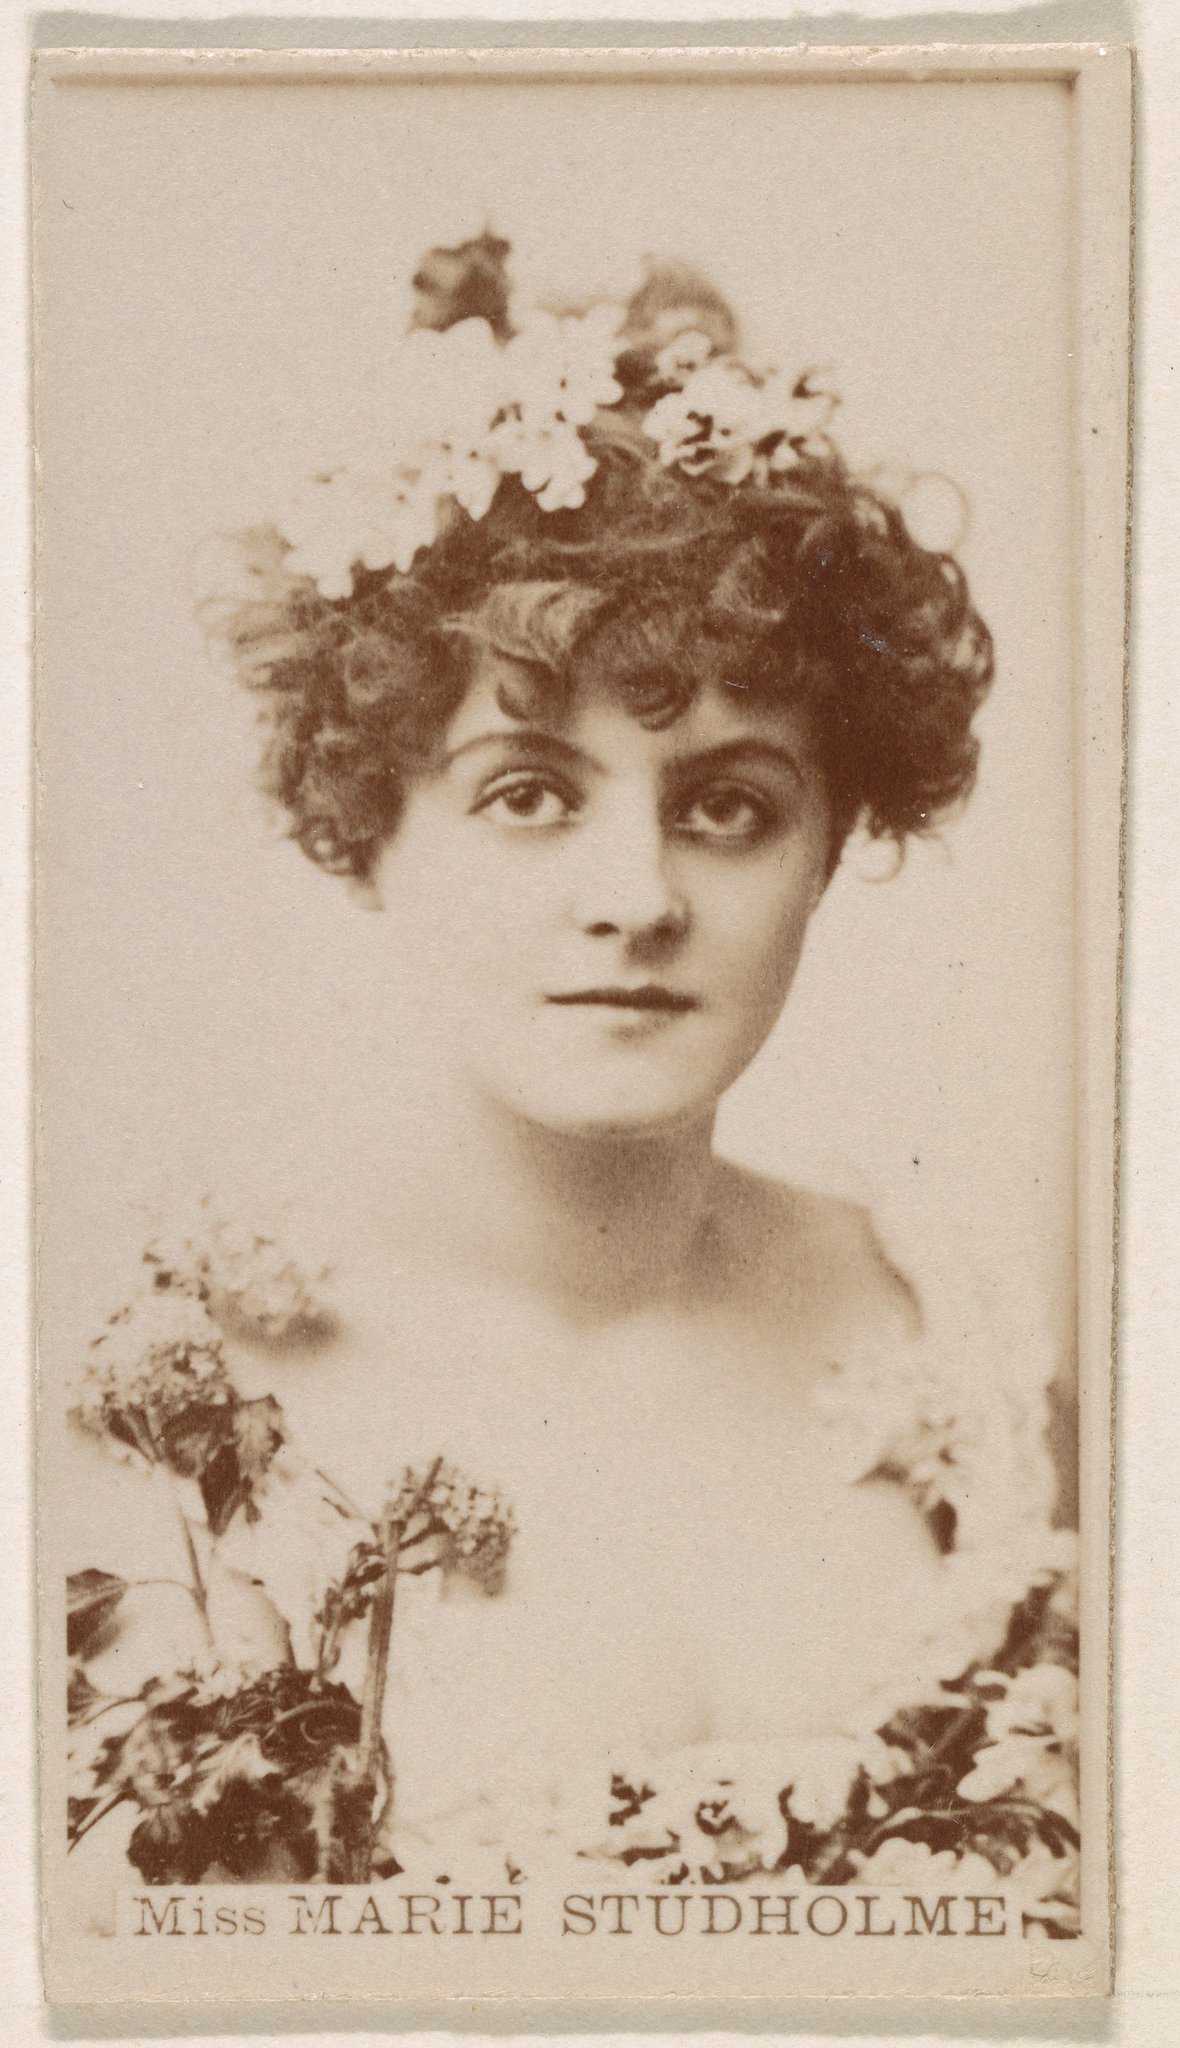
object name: photograph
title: Miss Marie Studholme, from the Actresses series (N245) issued by Kinney Brothers to promote Sweet Caporal Cigarettes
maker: kinney brothers tobacco company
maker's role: publisher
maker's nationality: american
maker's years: 1869-2011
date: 1890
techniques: albumen silver print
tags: portraits,women,actresses